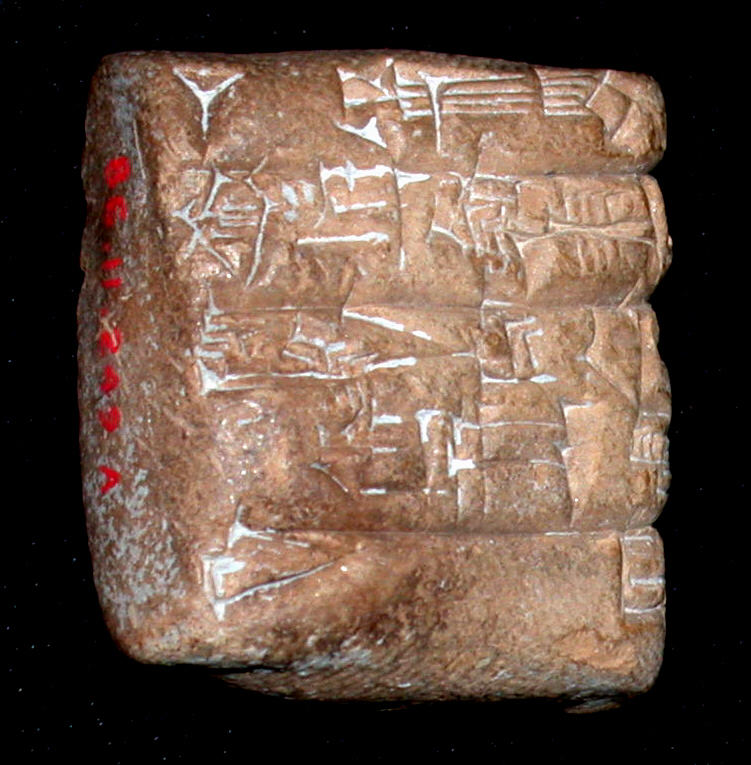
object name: cuneiform tablet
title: Cuneiform tablet: receipt of a kid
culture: neo-sumerian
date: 2051 BCE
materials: clay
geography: mesopotamia